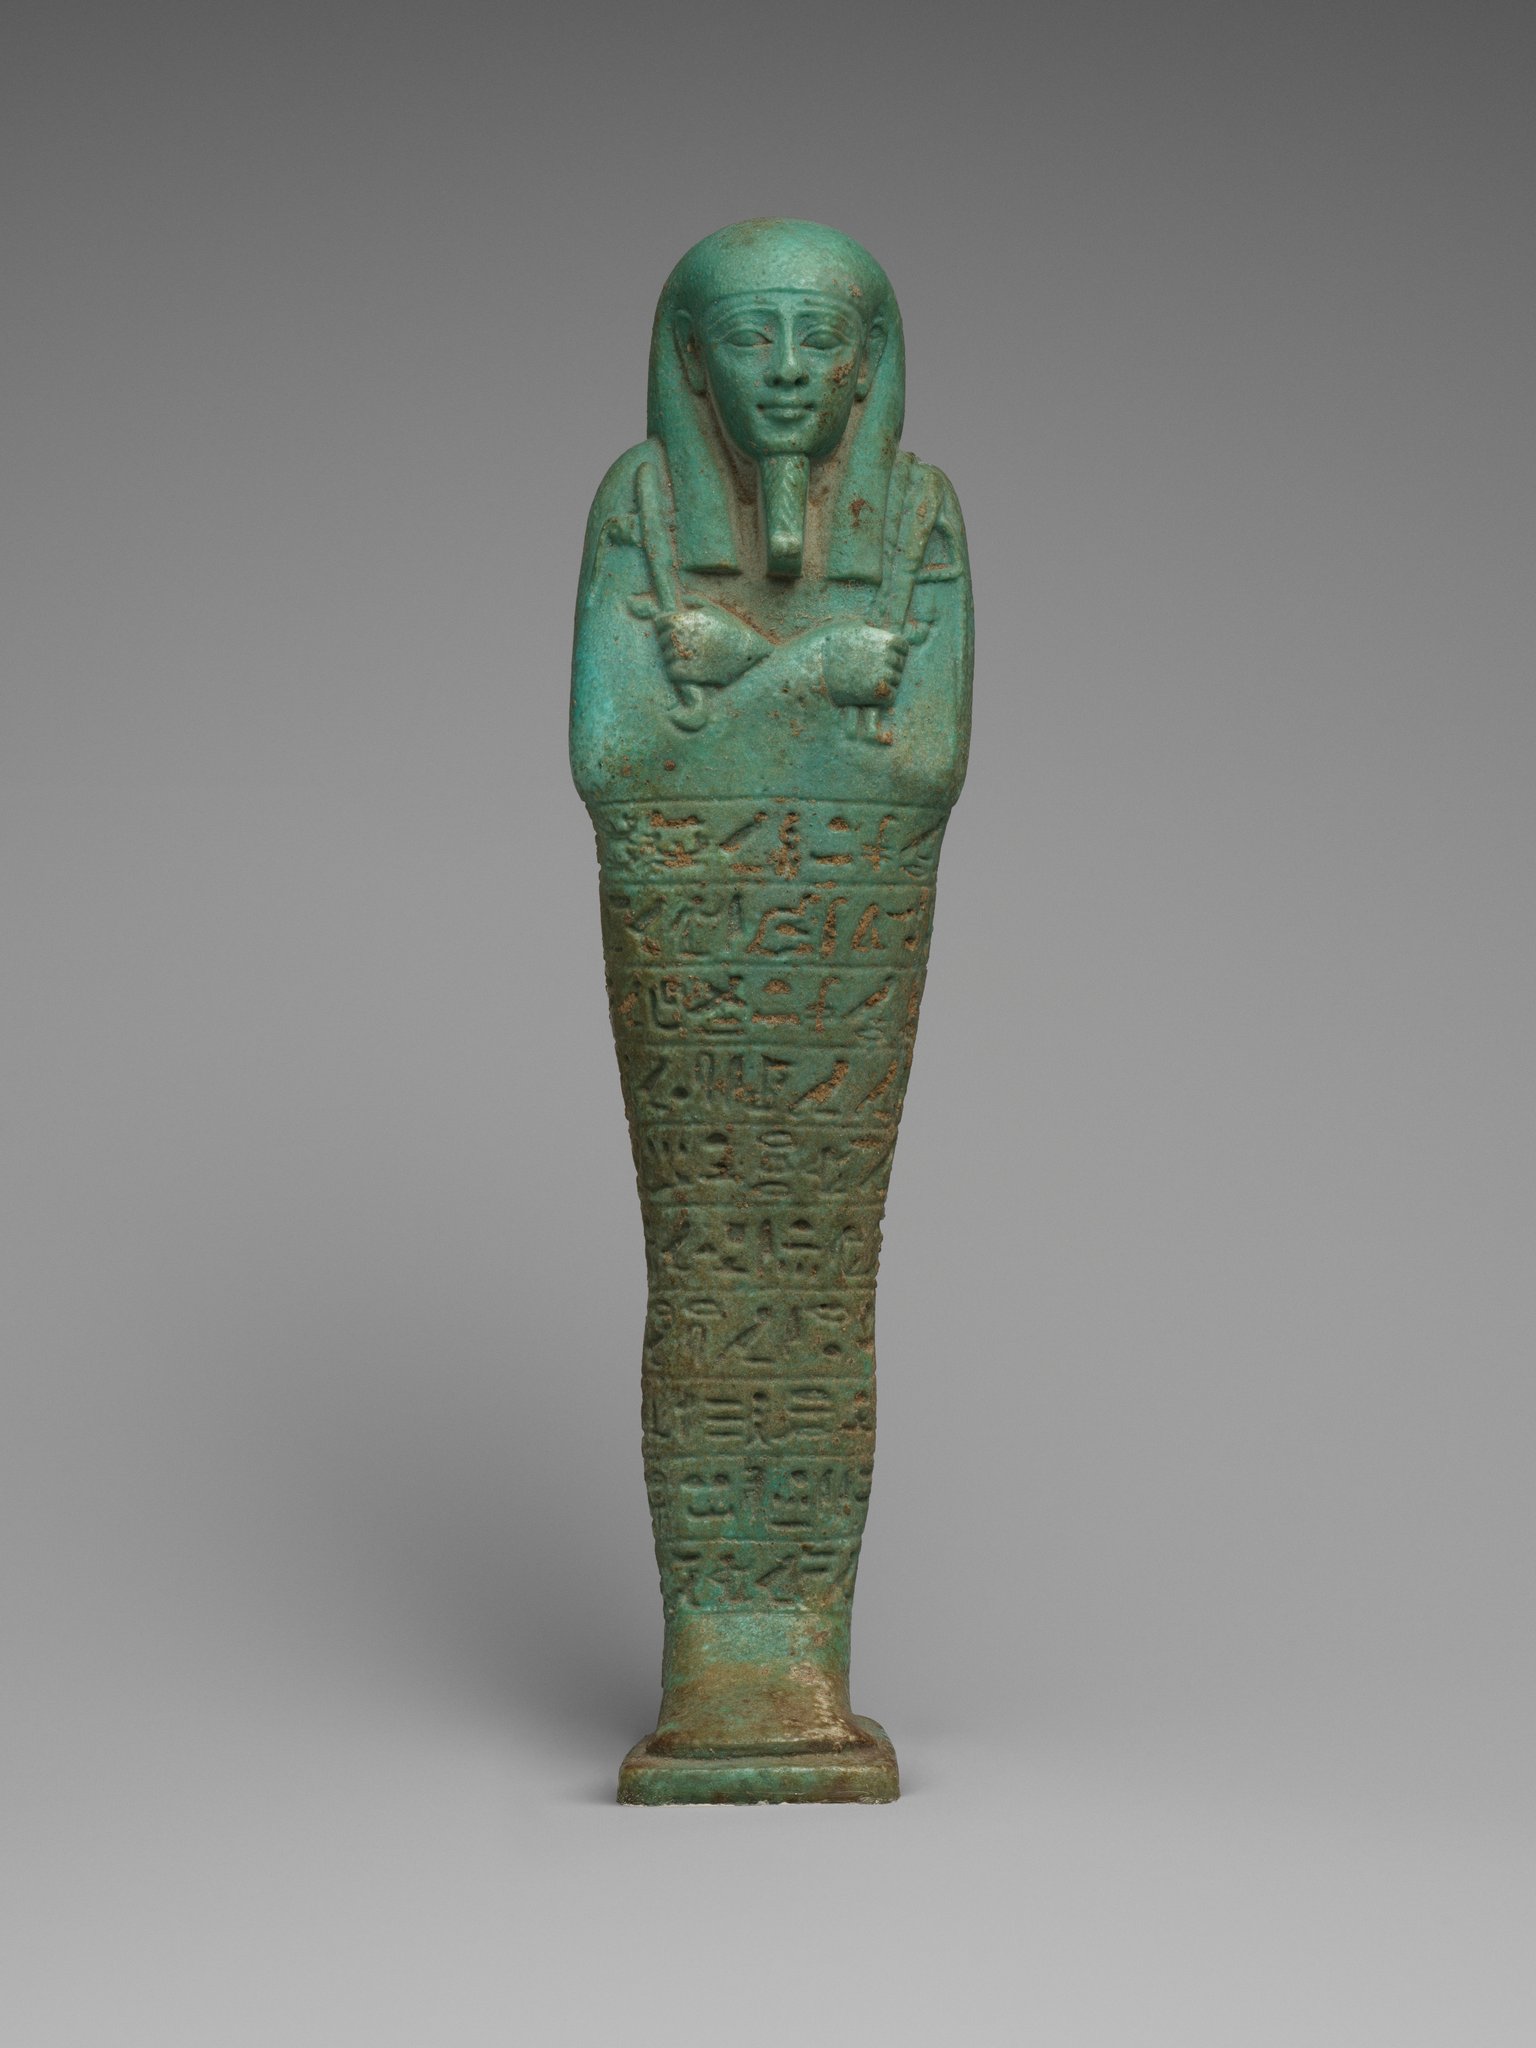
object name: shabti, tjanenhebu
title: Shabti of the Commander of the Royal Fleet Tjanenhebu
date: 570-526 BCE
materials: faience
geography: egypt